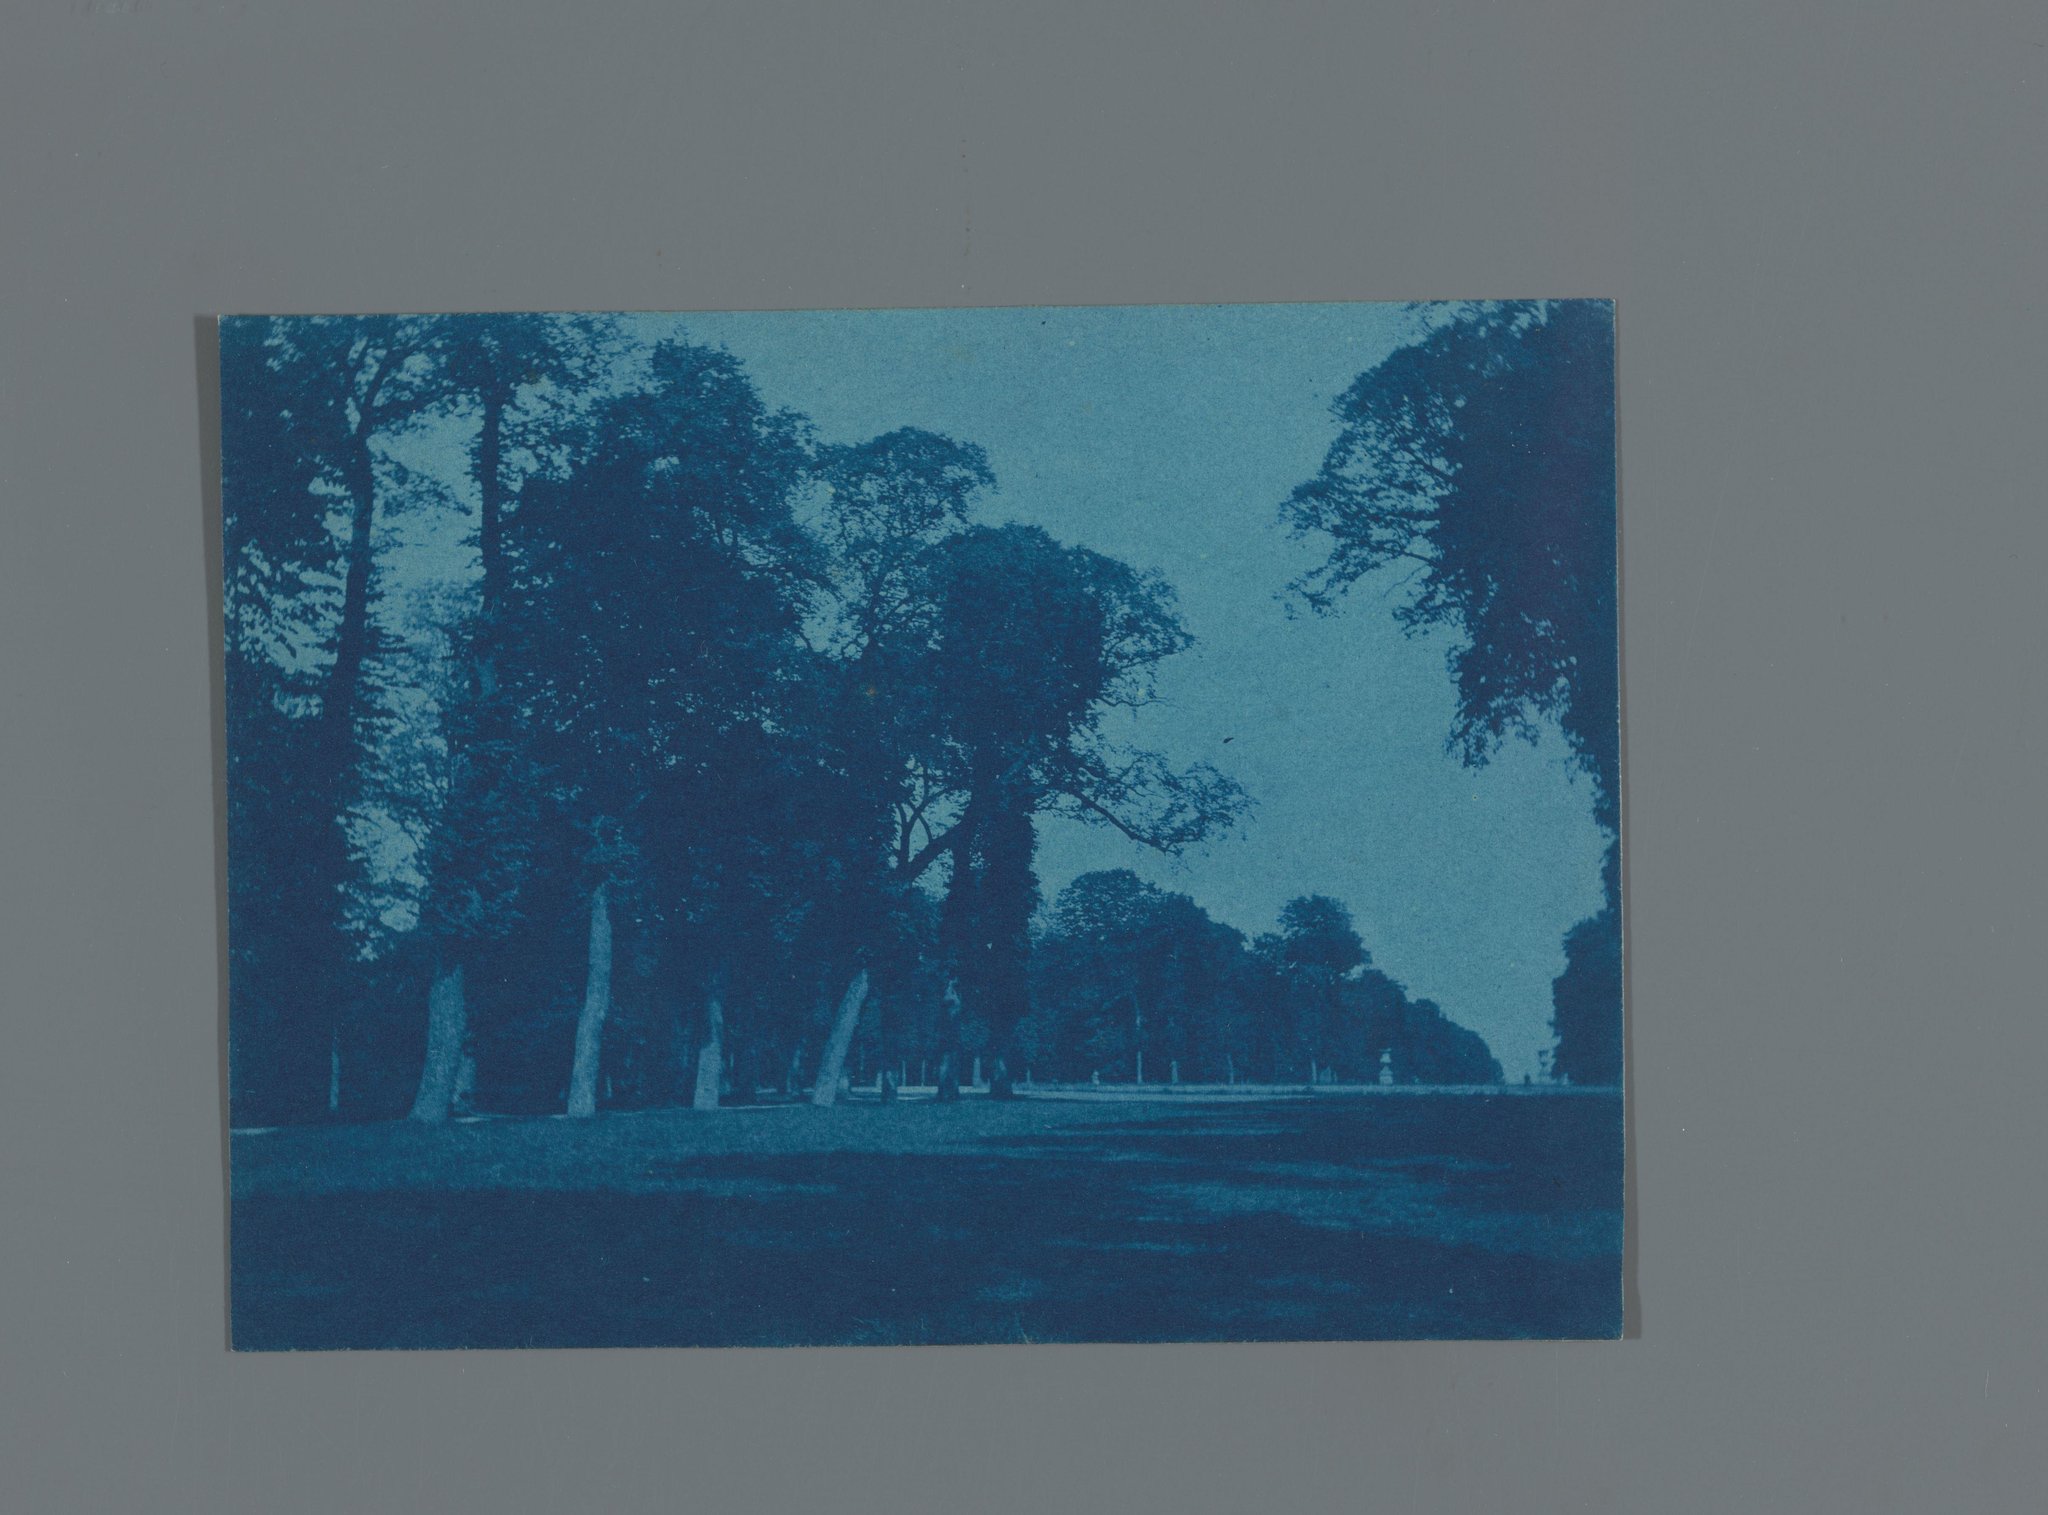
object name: photograph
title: Pavé de Chailly in het bos van Fontainebleau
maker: louis cabat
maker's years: 1812-1893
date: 1890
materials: paper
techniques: cyanotype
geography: fontainebleau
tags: forest path or lane